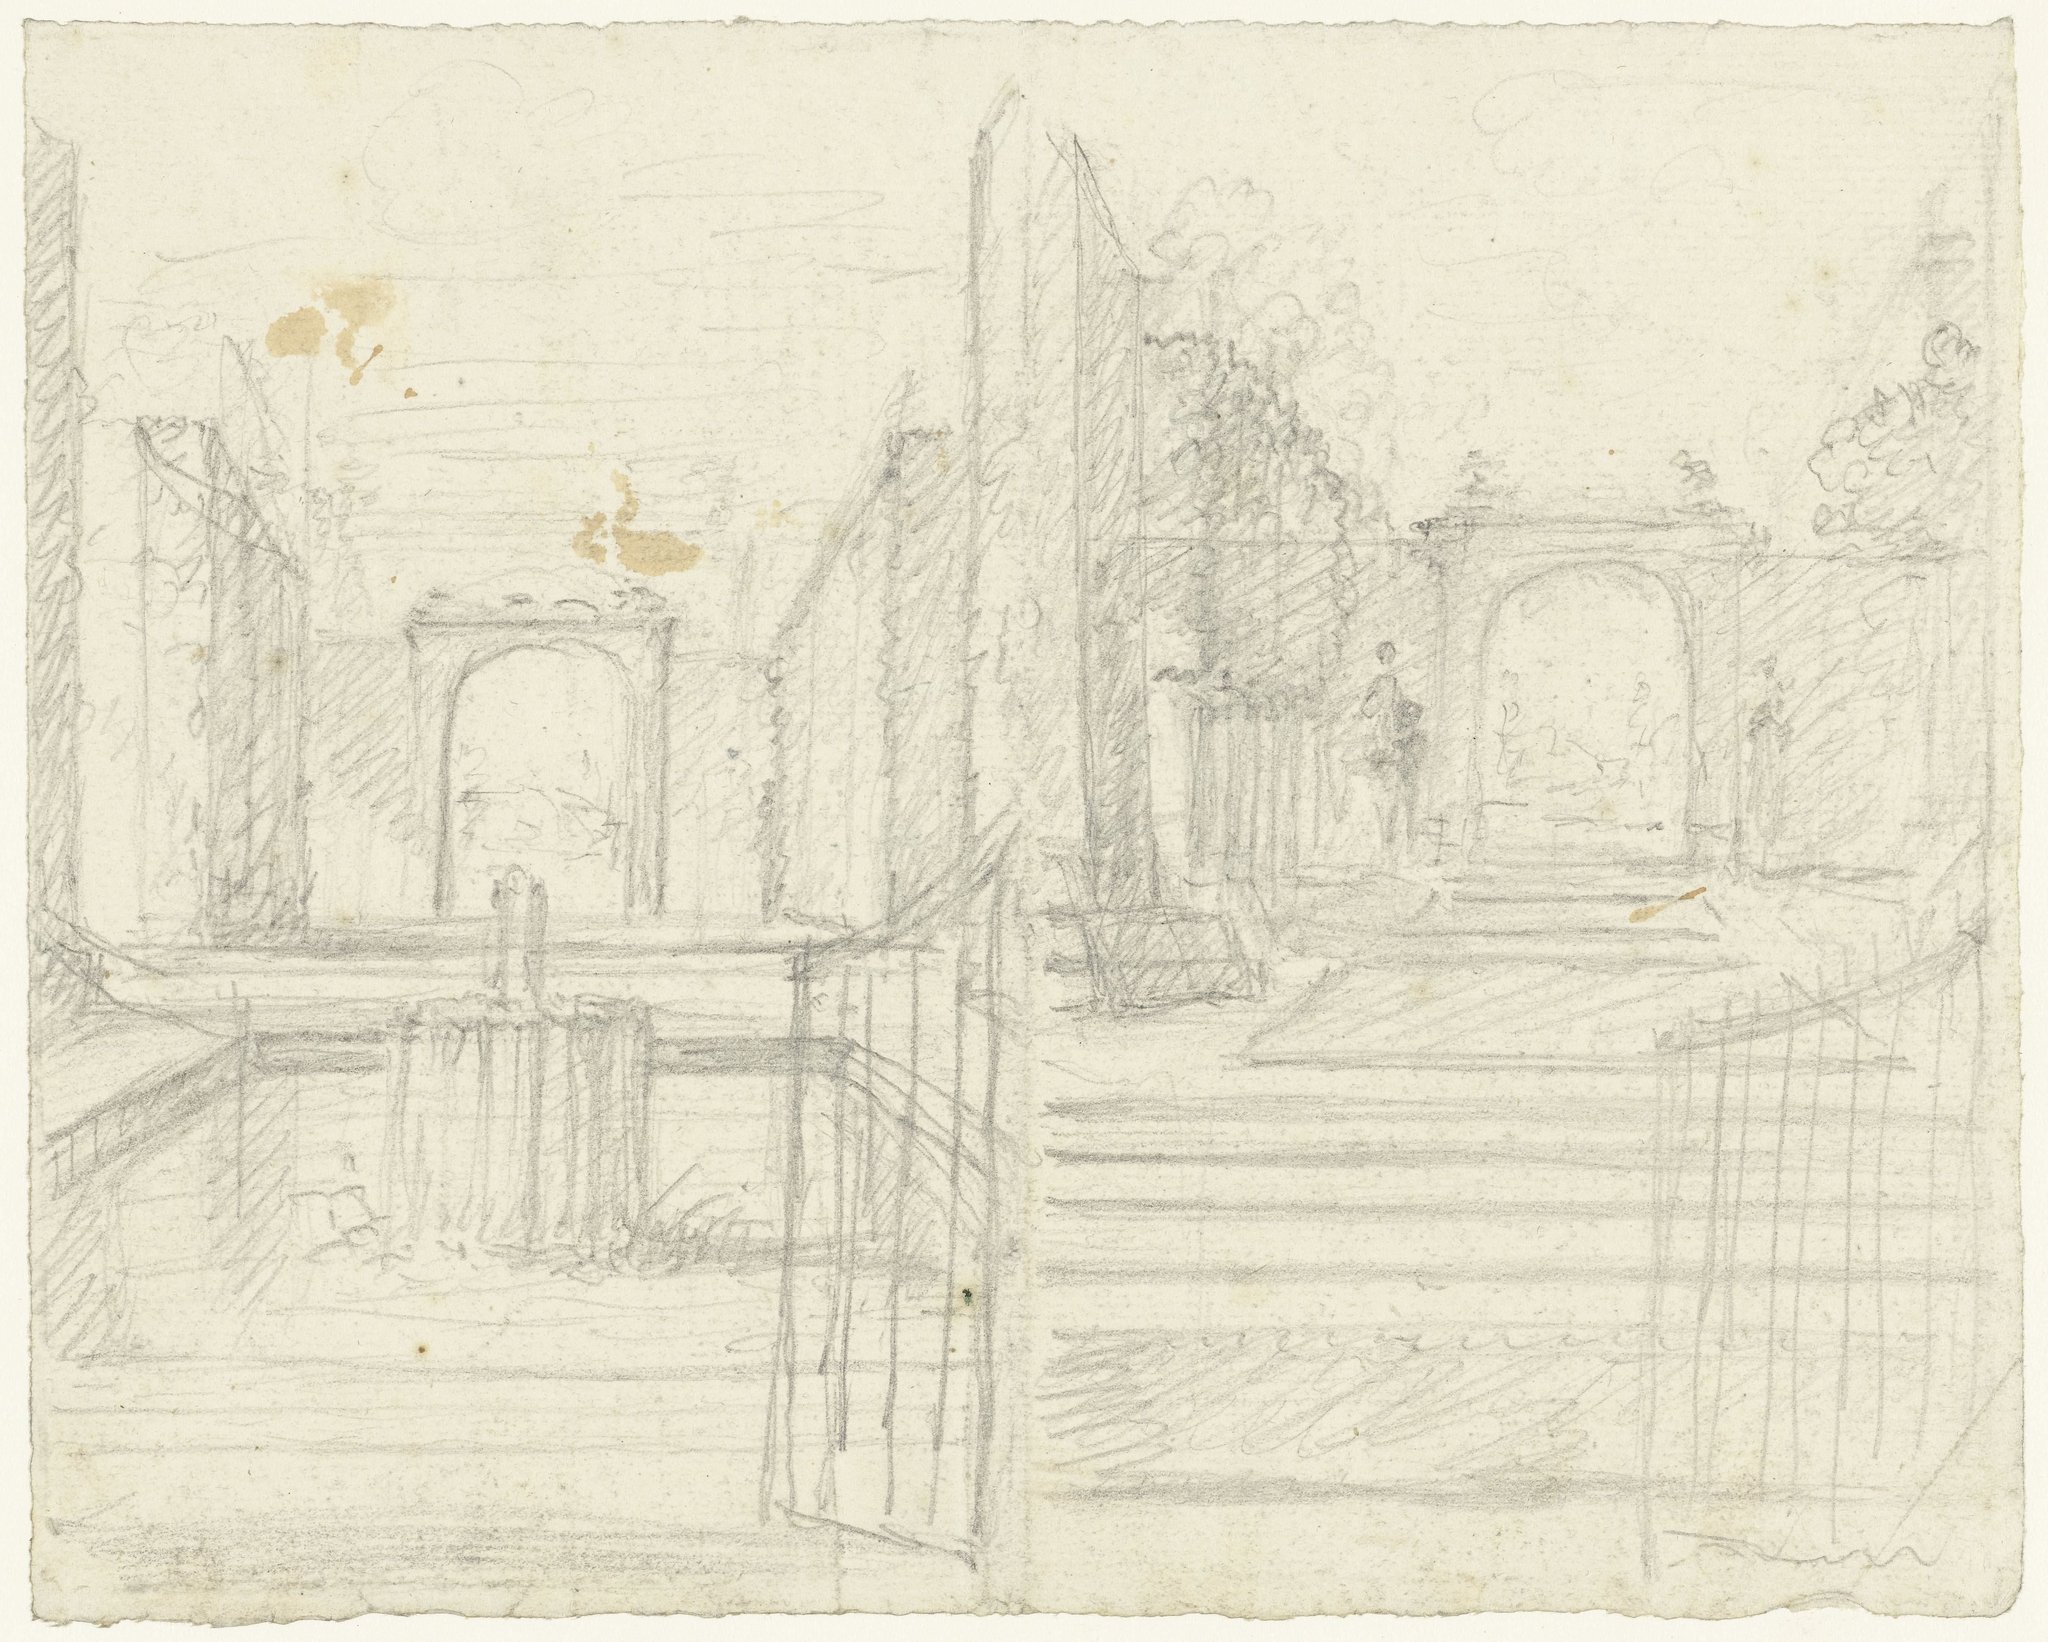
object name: design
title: Twee schetsen van een tuin met een vijver, op de voorgrond een openstaand hek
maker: dionys van nijmegen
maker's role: draughtsman, painter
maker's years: 1705-1798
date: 1715-1798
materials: paper, pencil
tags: garden